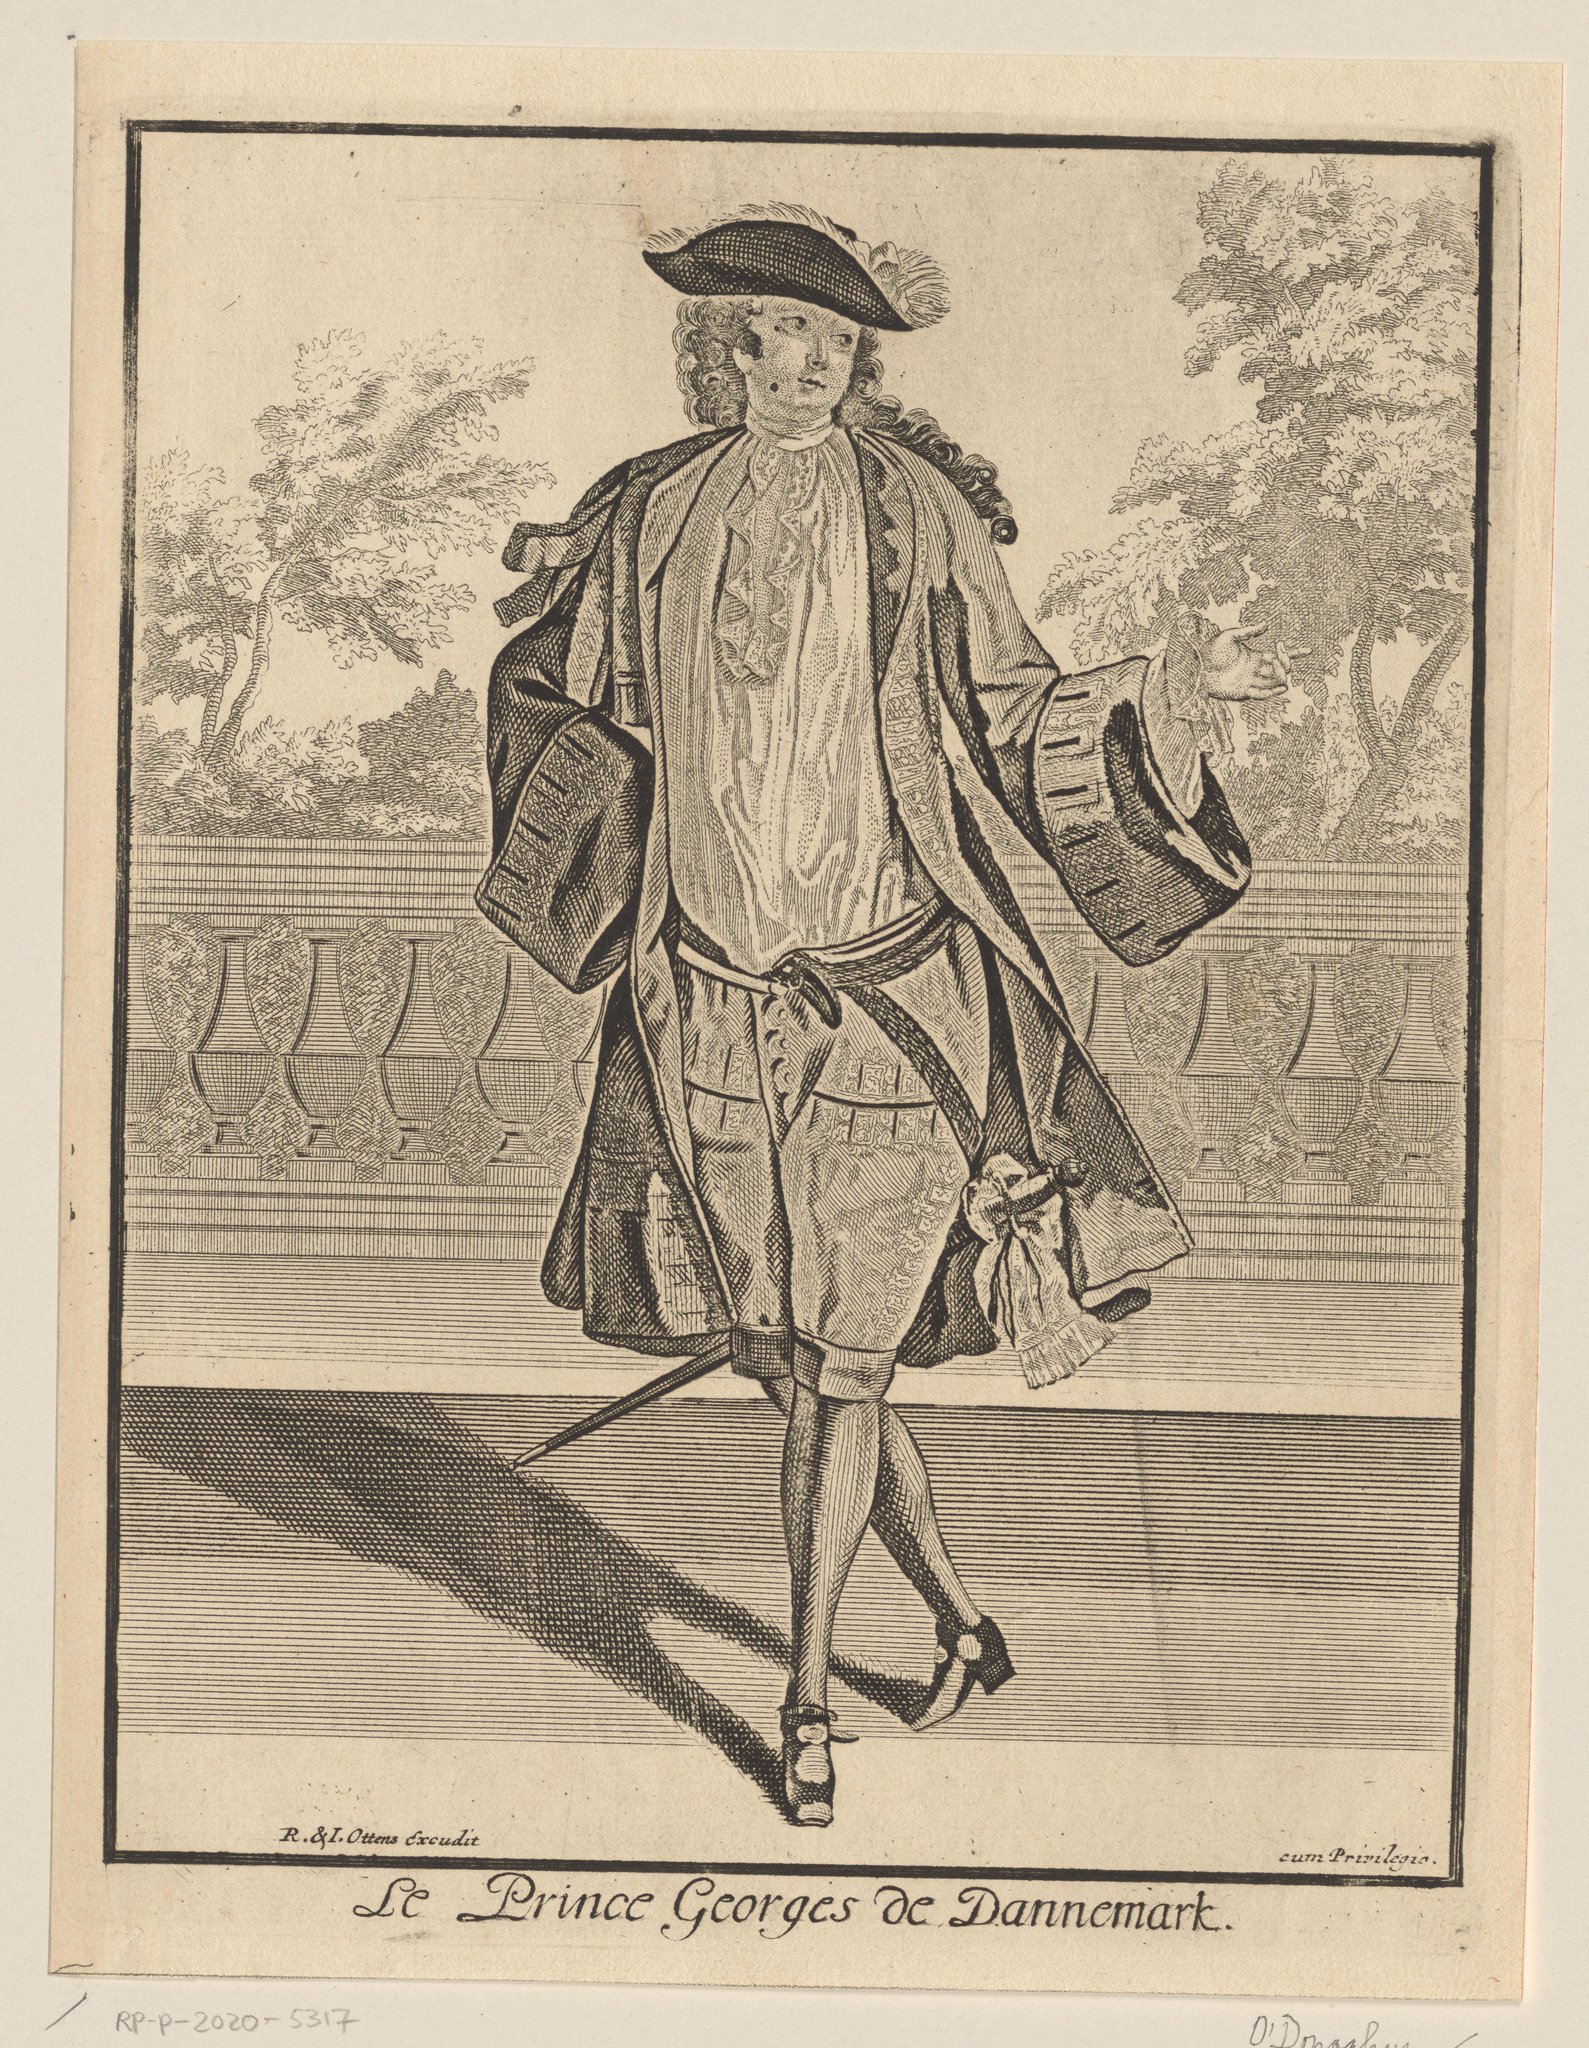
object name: print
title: Portret van George, prins van Denemarken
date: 1726-1760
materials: paper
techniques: engraving, etching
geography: amsterdam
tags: george (prins van denemarken), prince, historical persons